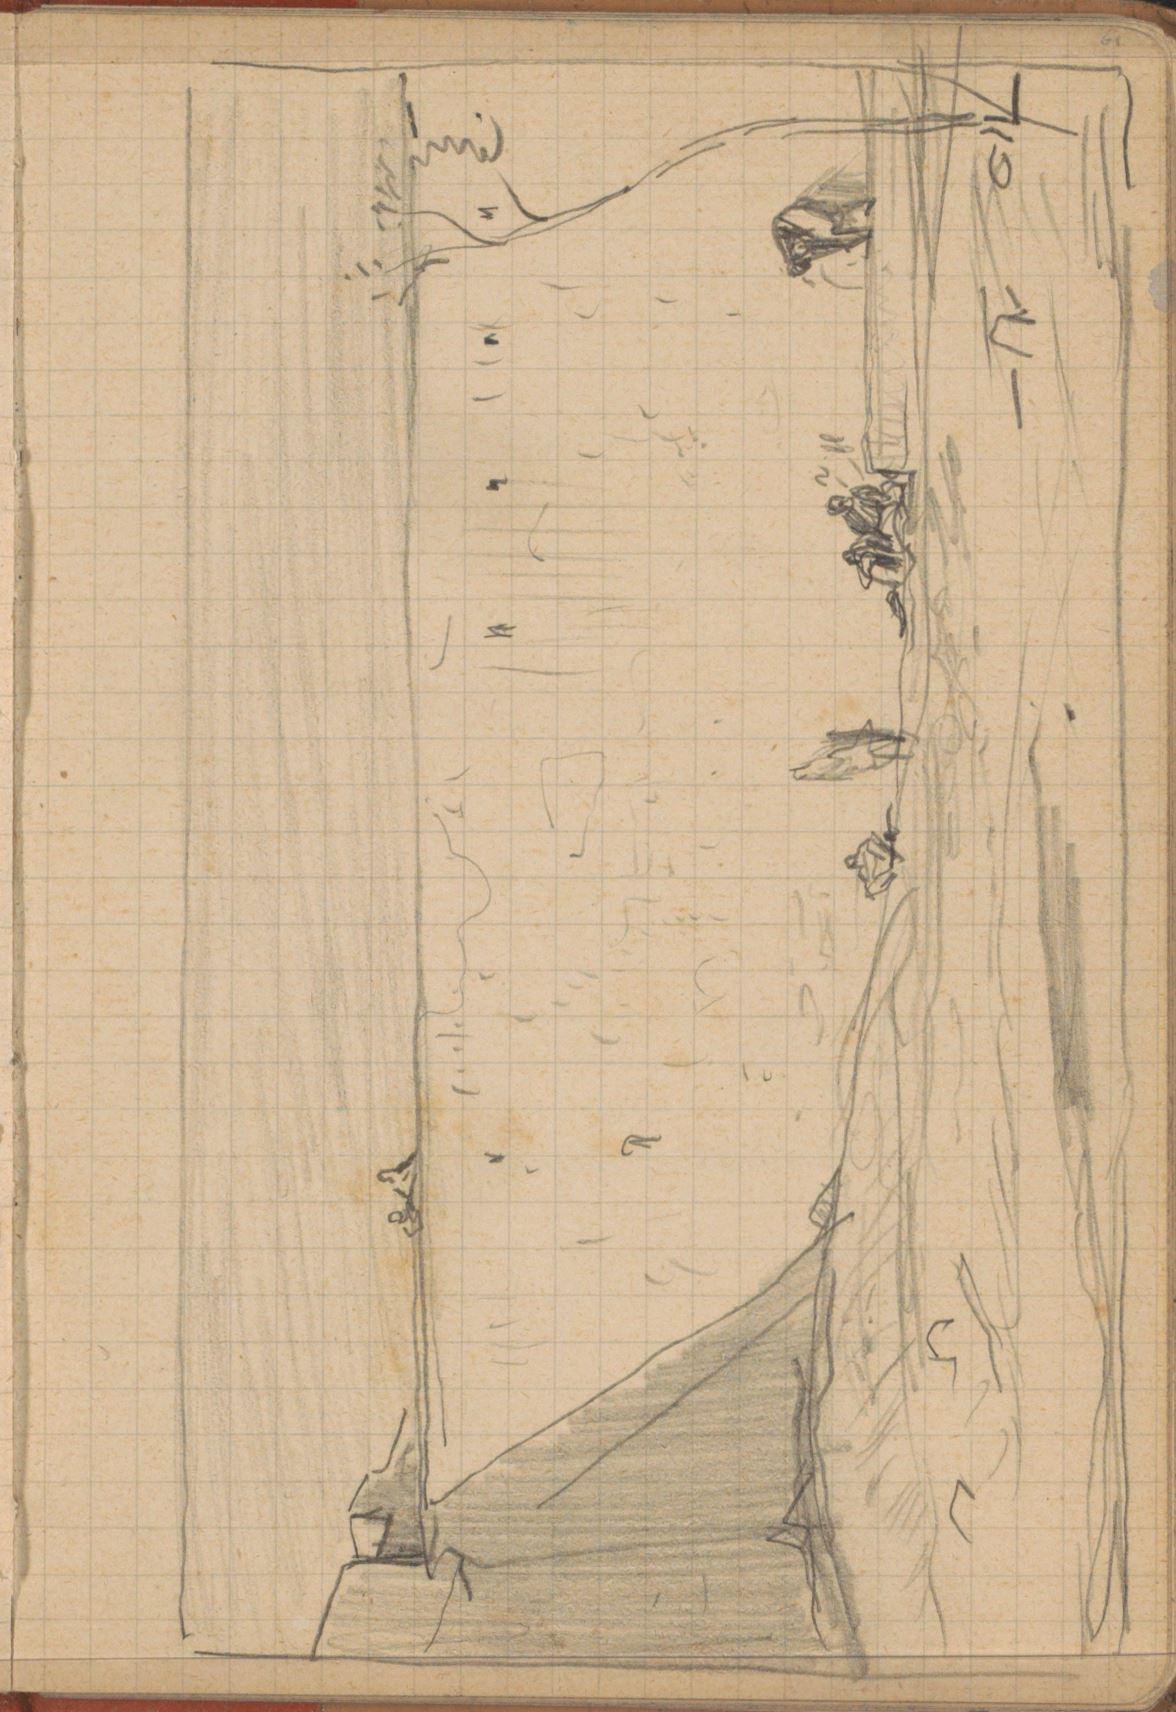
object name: sketchbook leaf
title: Figuren op een binnenplaats naast een muur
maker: marius bauer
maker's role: draughtsman, print maker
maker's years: 1867-1932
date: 1909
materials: pencil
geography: tunis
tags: courtyard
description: Pagina 61 uit een schetsboek met 67 bladen.